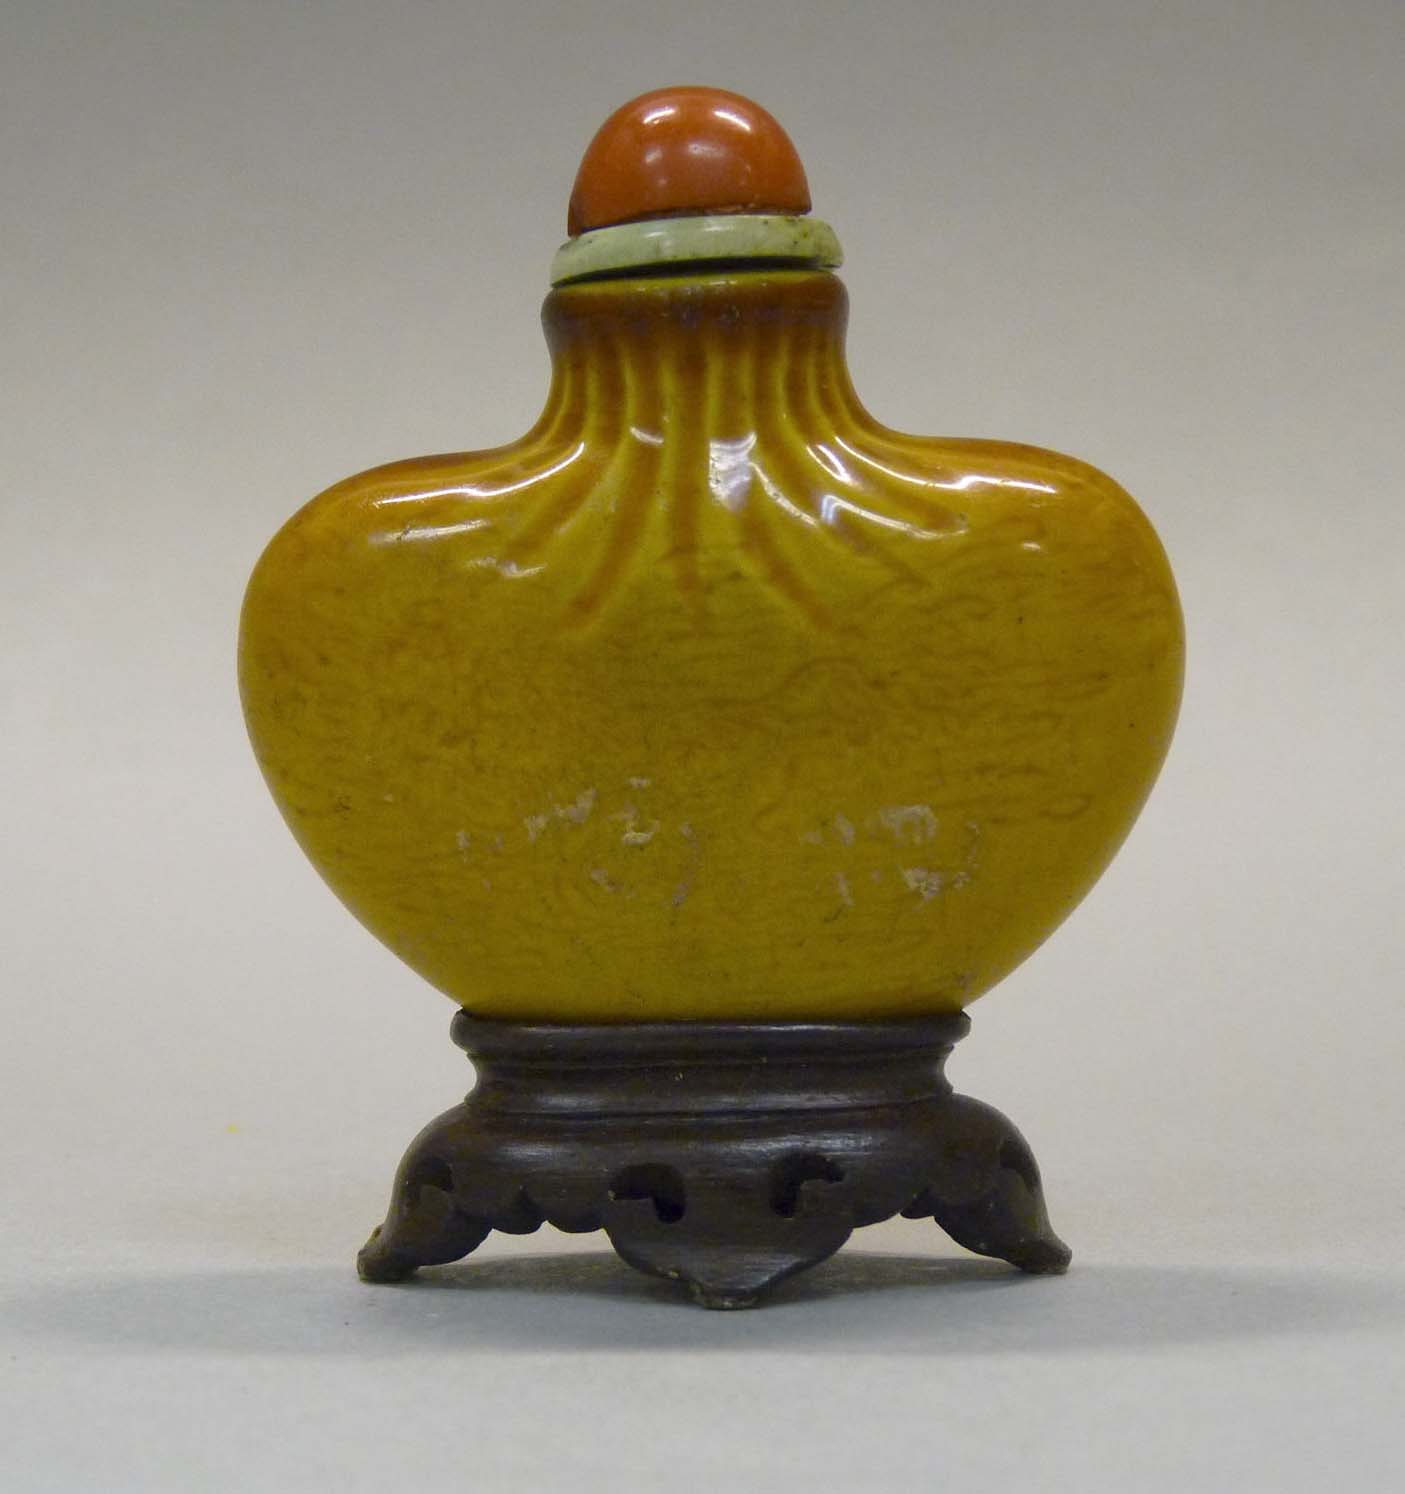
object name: snuff bottle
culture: chinese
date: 1736-1795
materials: glass, porcelain, wood